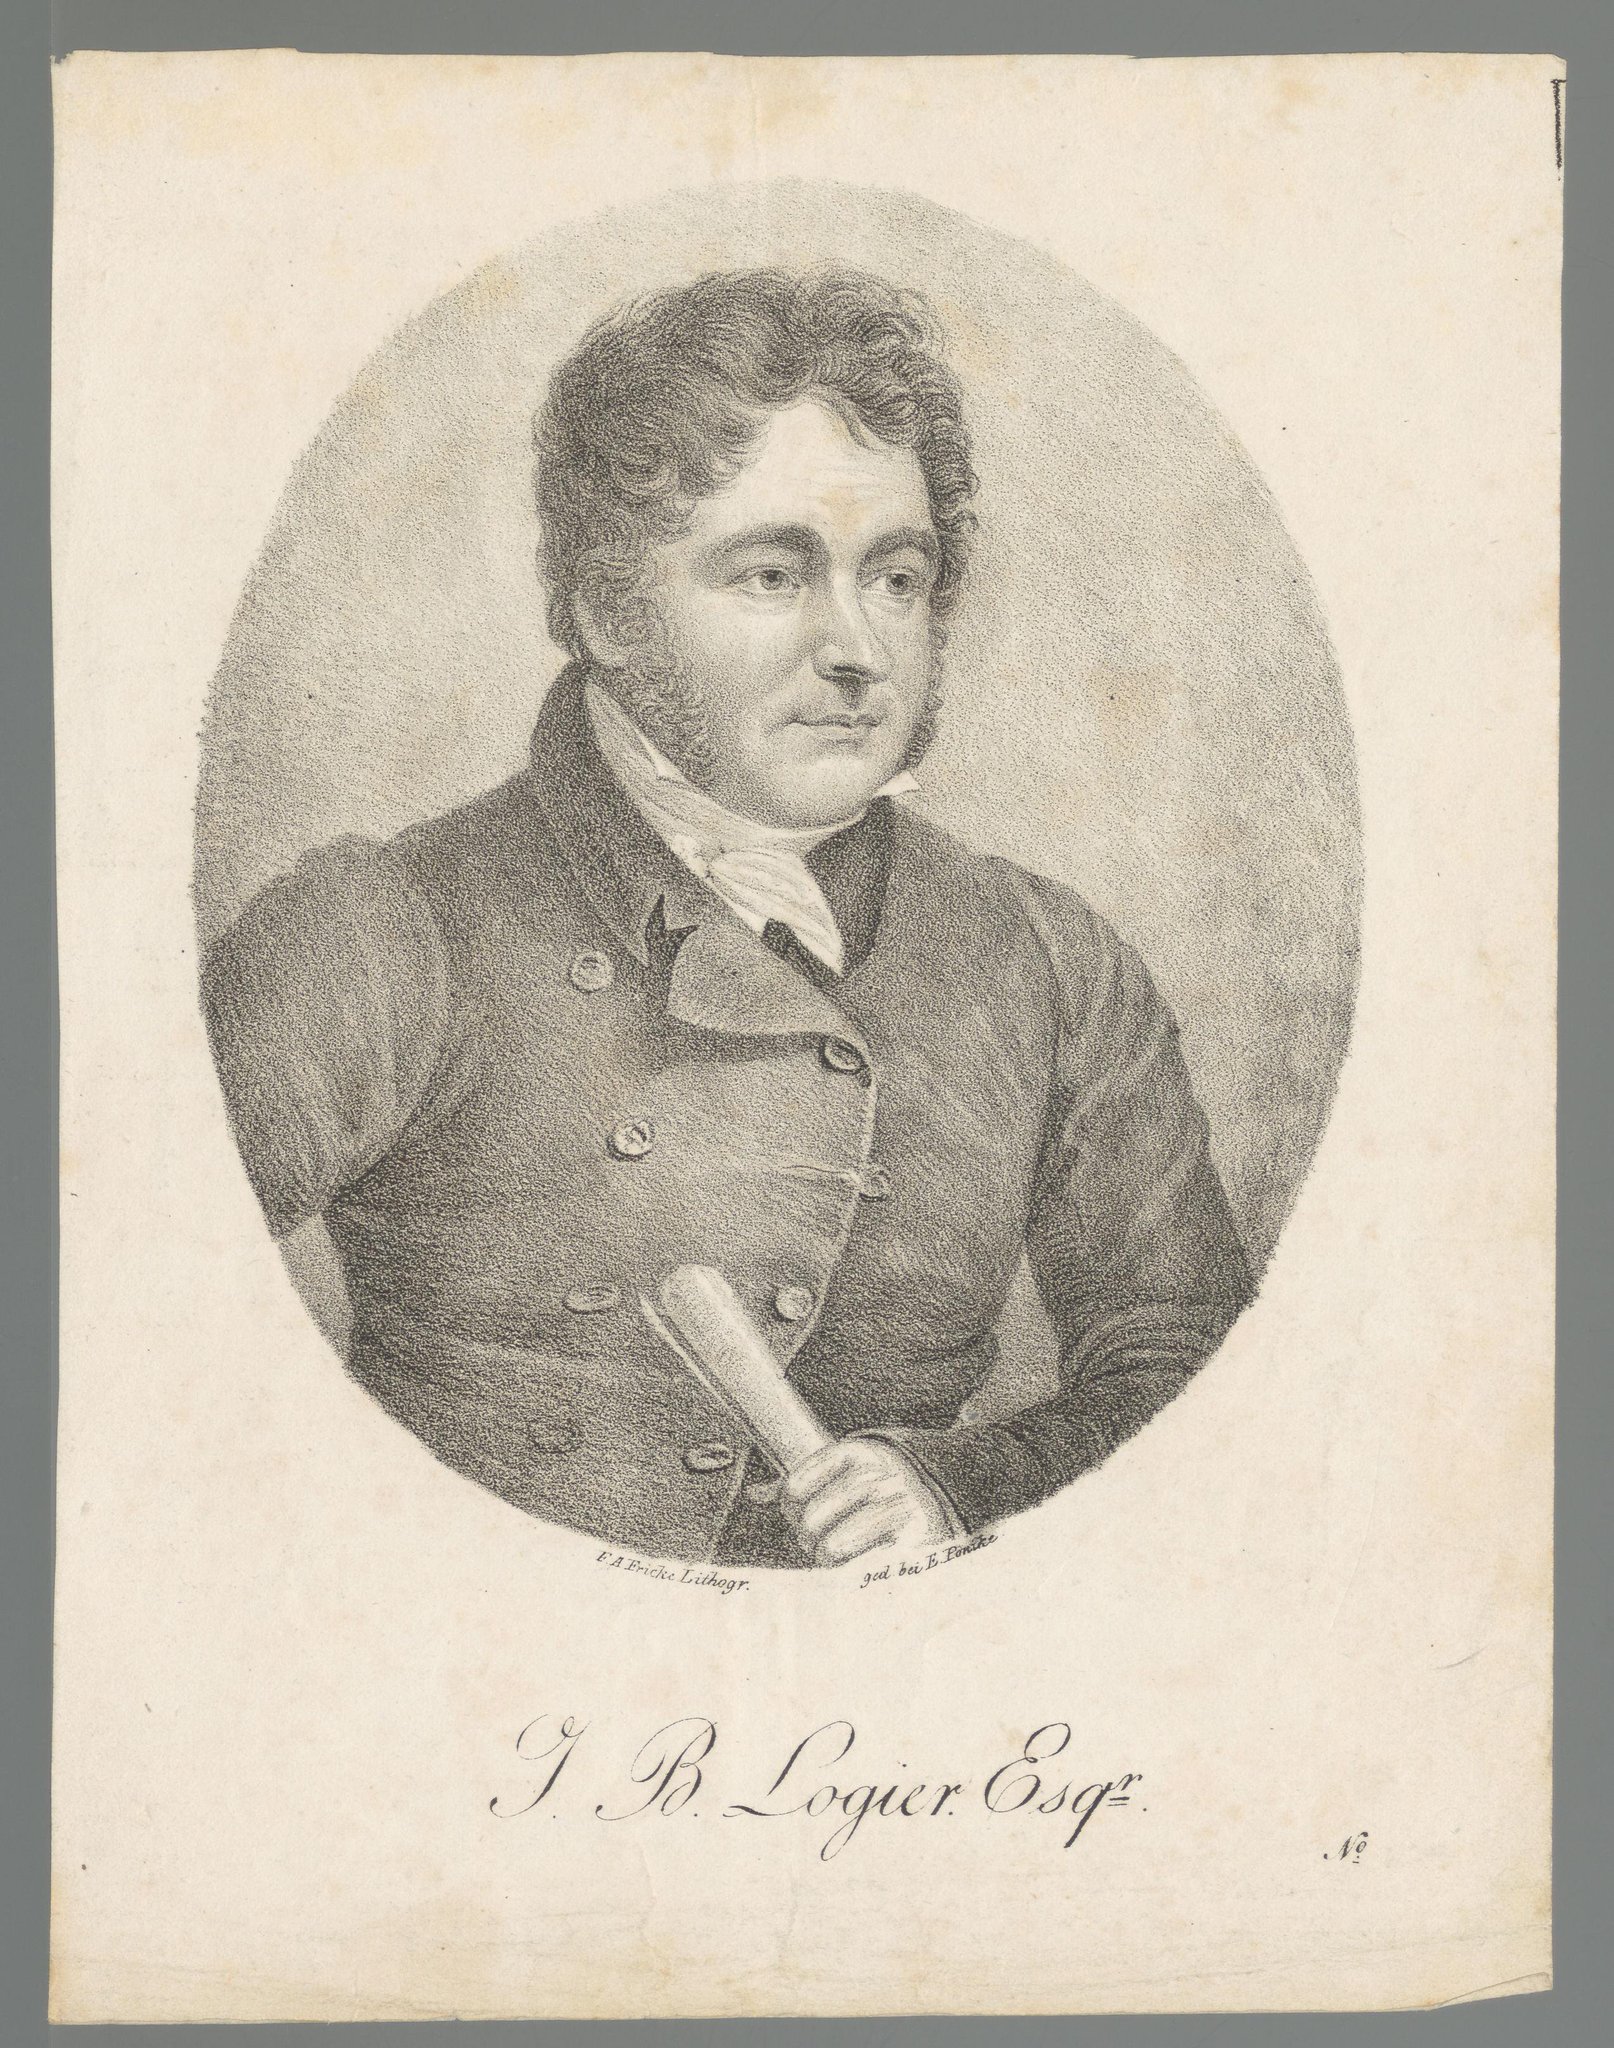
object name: print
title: J.B. Logier Esq.r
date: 1794-1858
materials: paper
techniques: lithograph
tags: adult man, historical persons, scroll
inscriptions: collector's mark: Lugt 2228